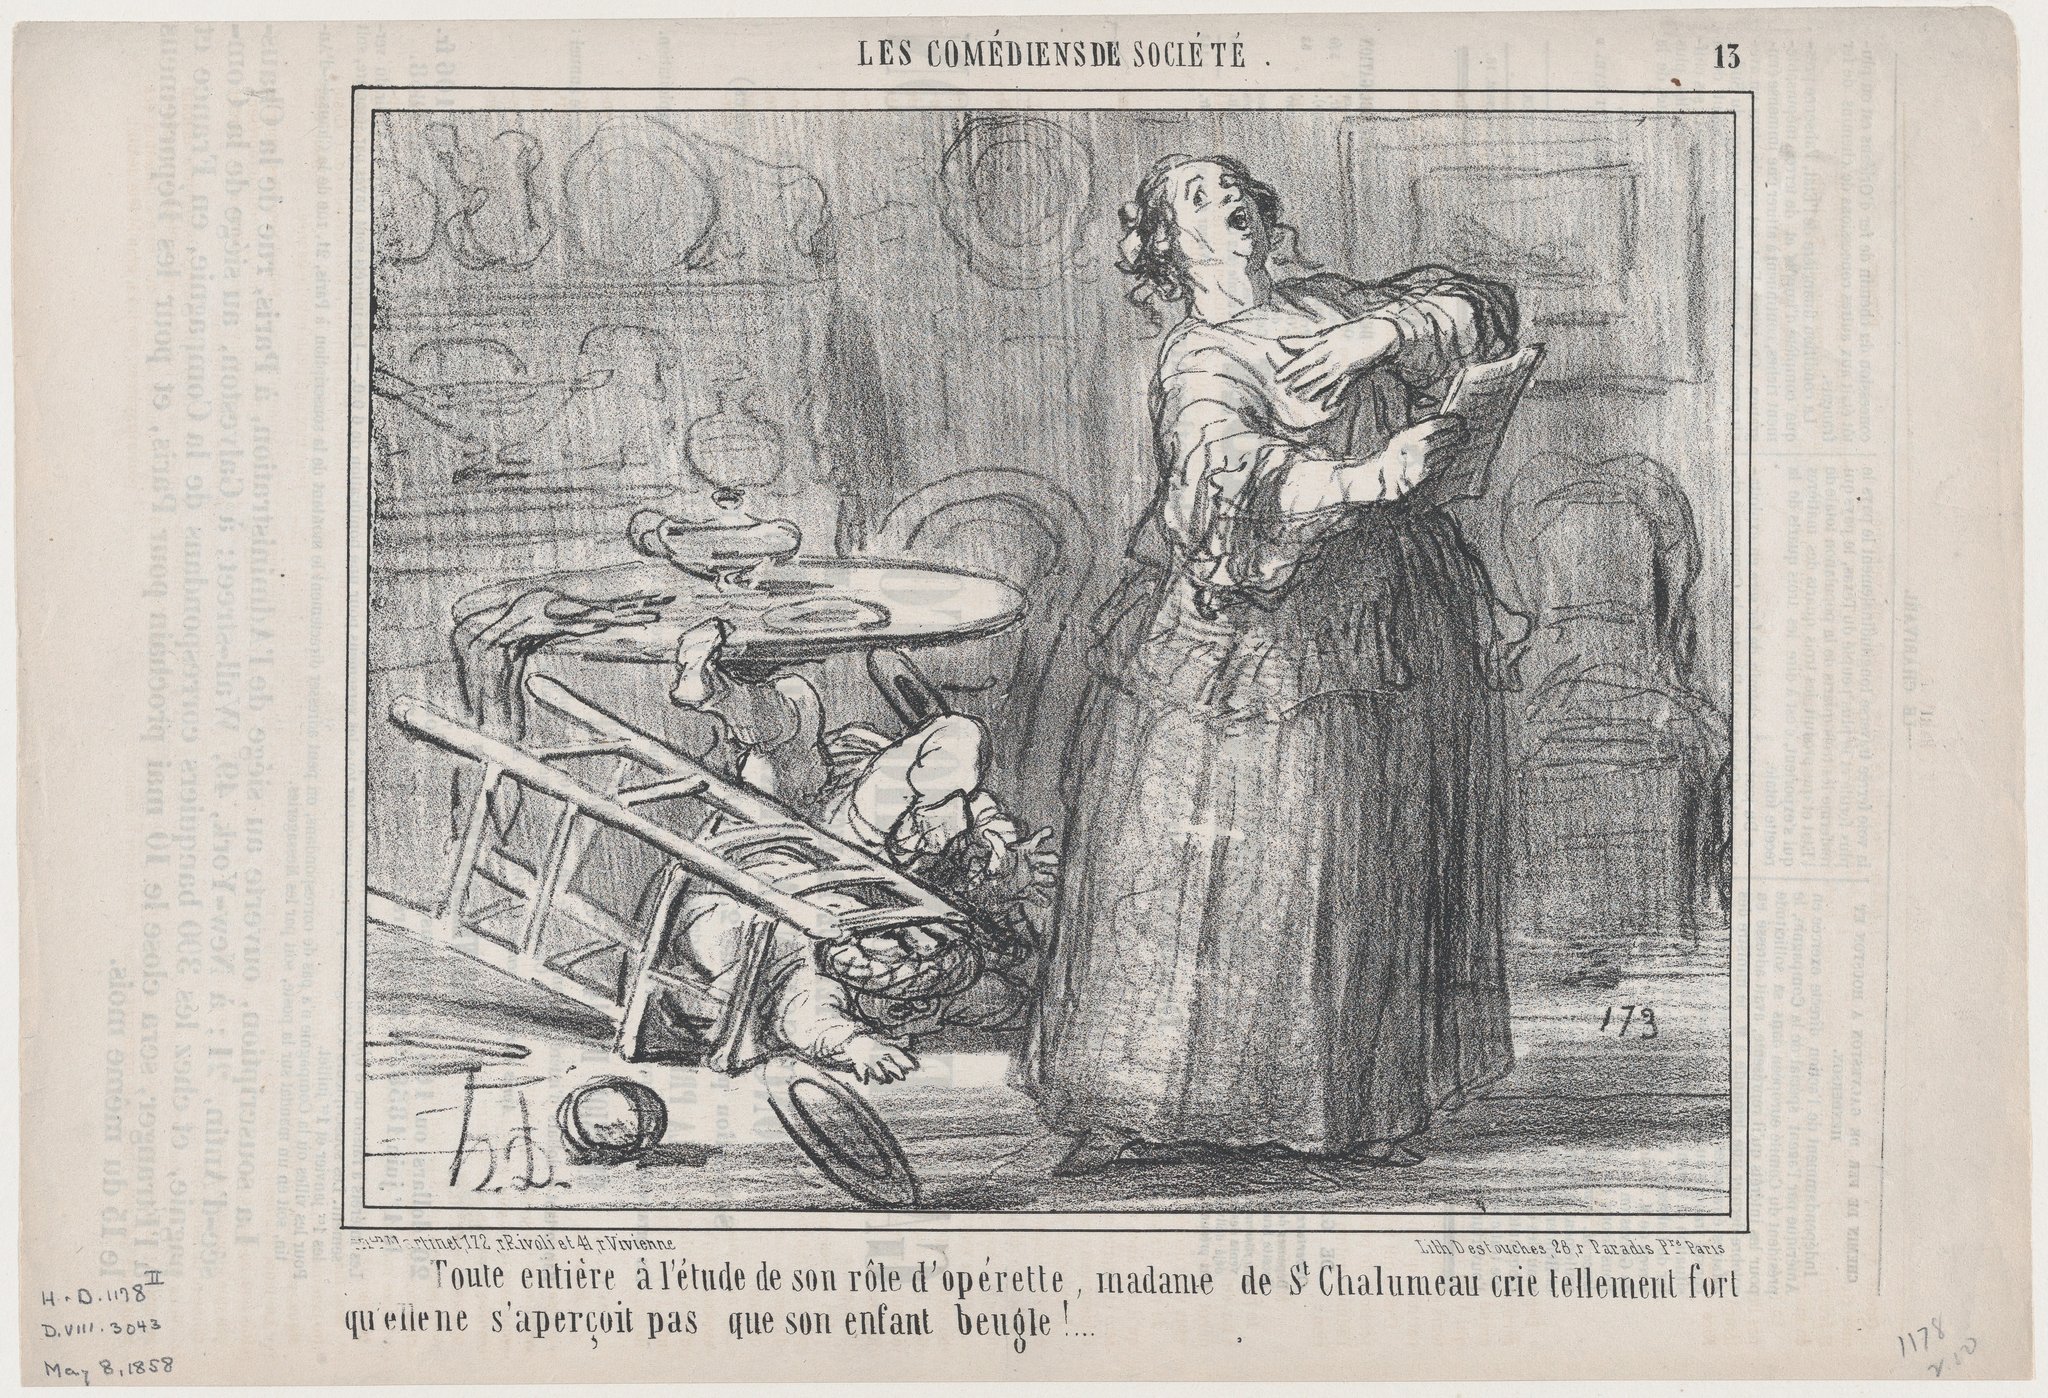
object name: print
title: Toute entière à l'étude de son rôle d'opérette..., from "Les Comediens de Société"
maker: honoré daumier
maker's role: artist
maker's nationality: french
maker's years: 1808-1879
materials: paper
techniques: lithograph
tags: opera,women